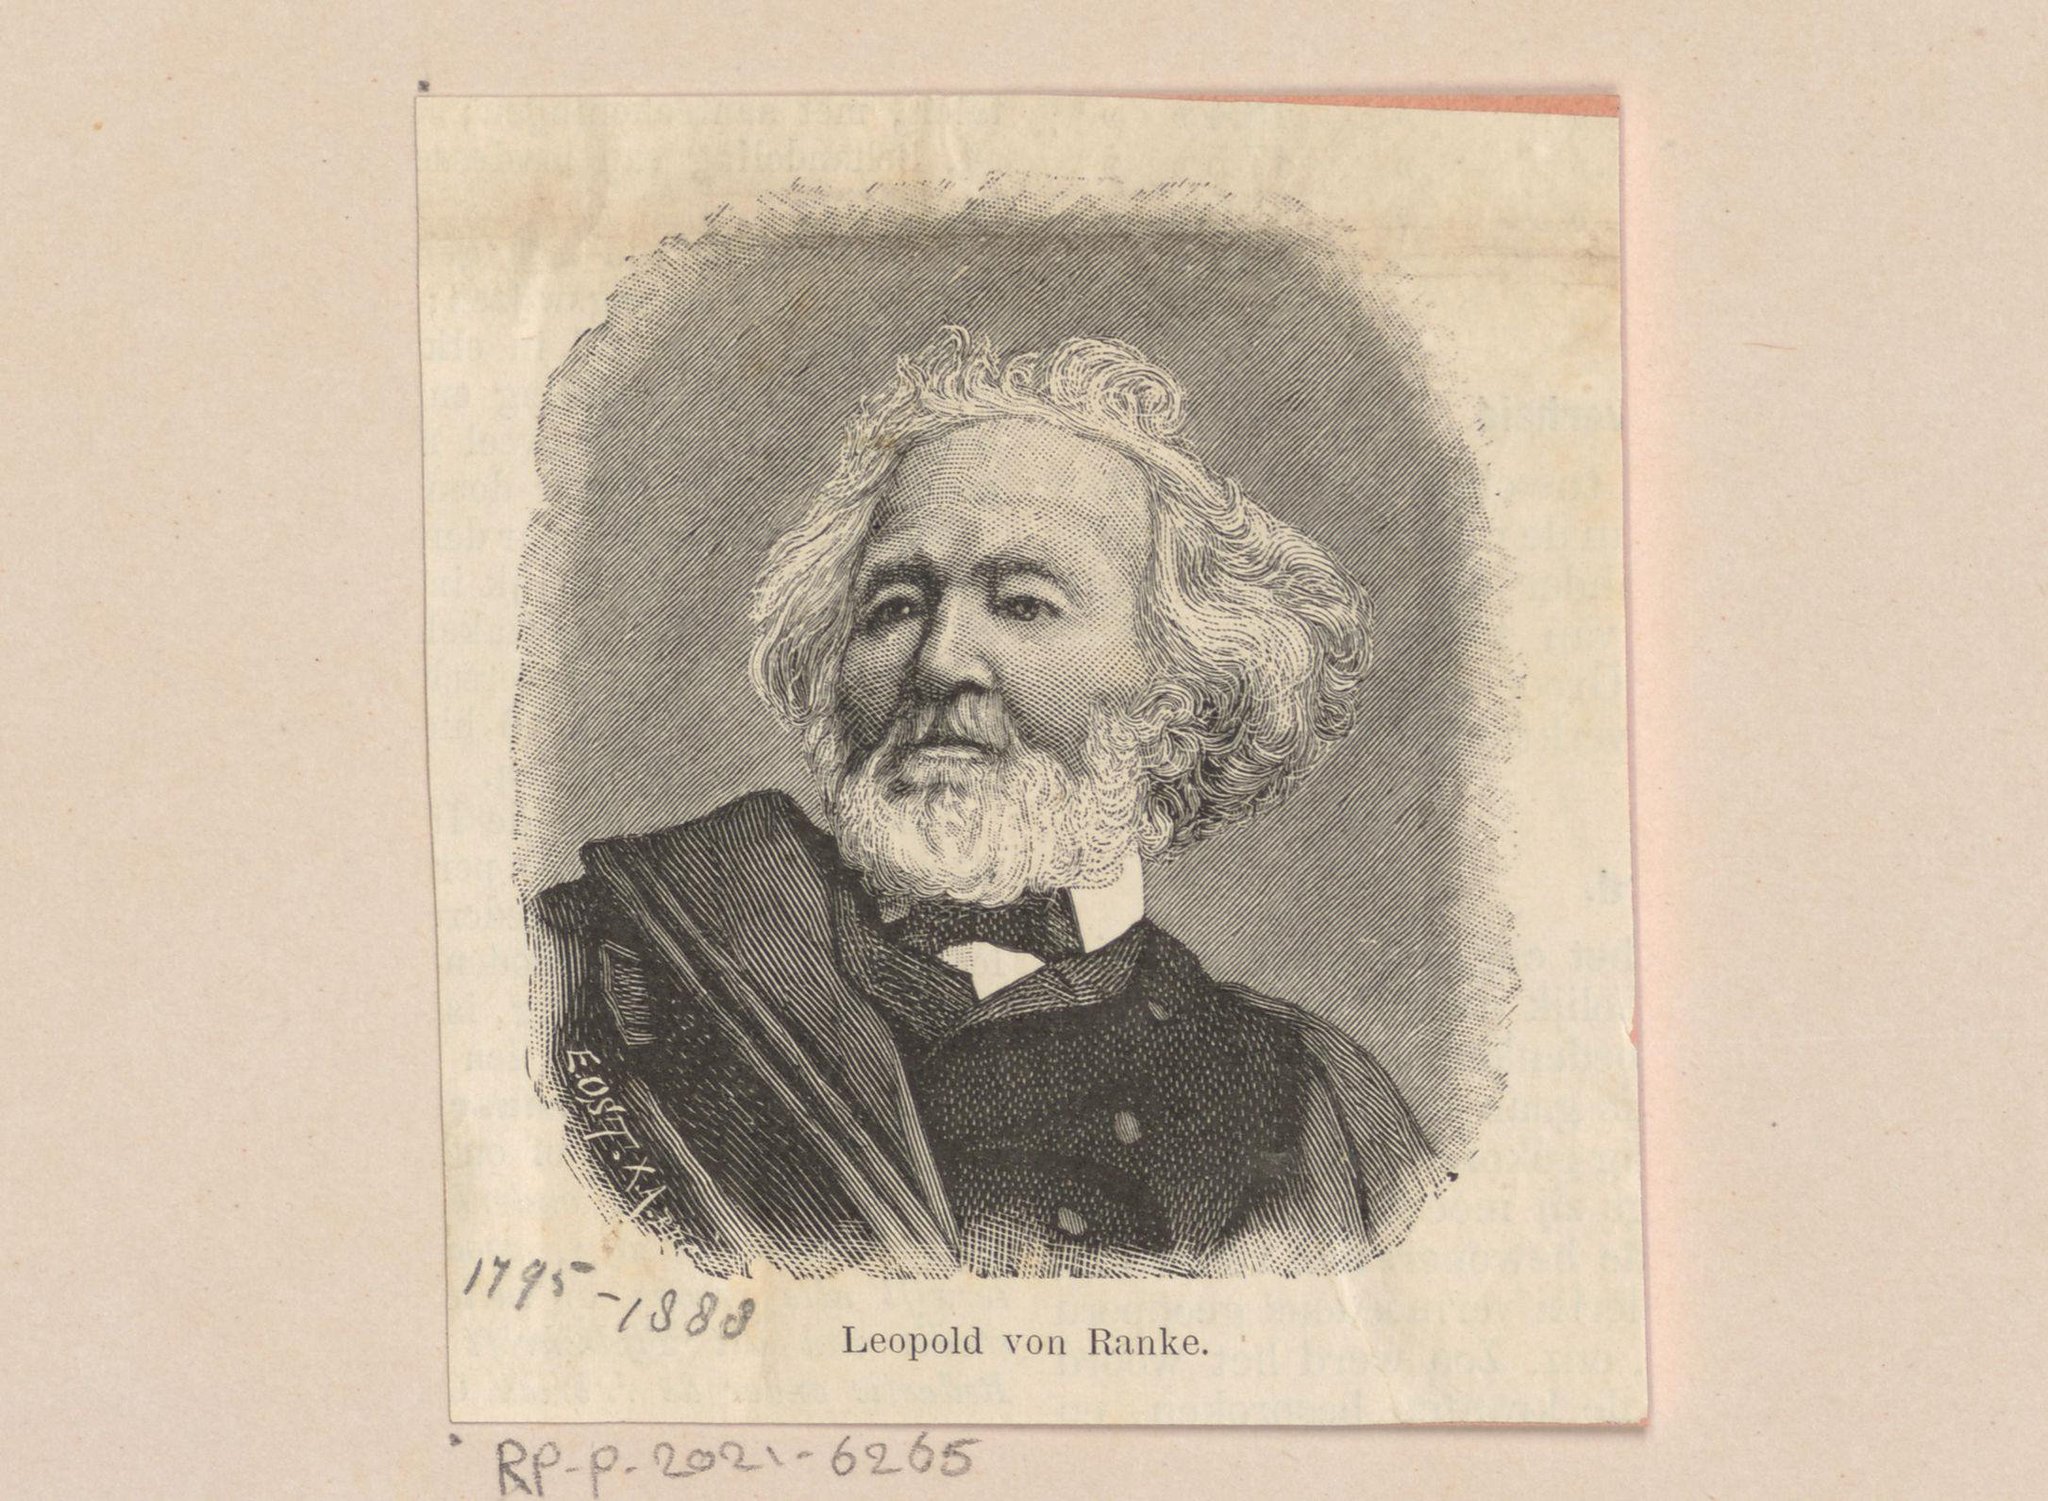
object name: print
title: Portret van Leopold von Ranke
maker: emil ost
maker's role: print maker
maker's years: 1846-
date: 1856-1949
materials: paper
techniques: letterpress printing, engraving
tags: historical persons